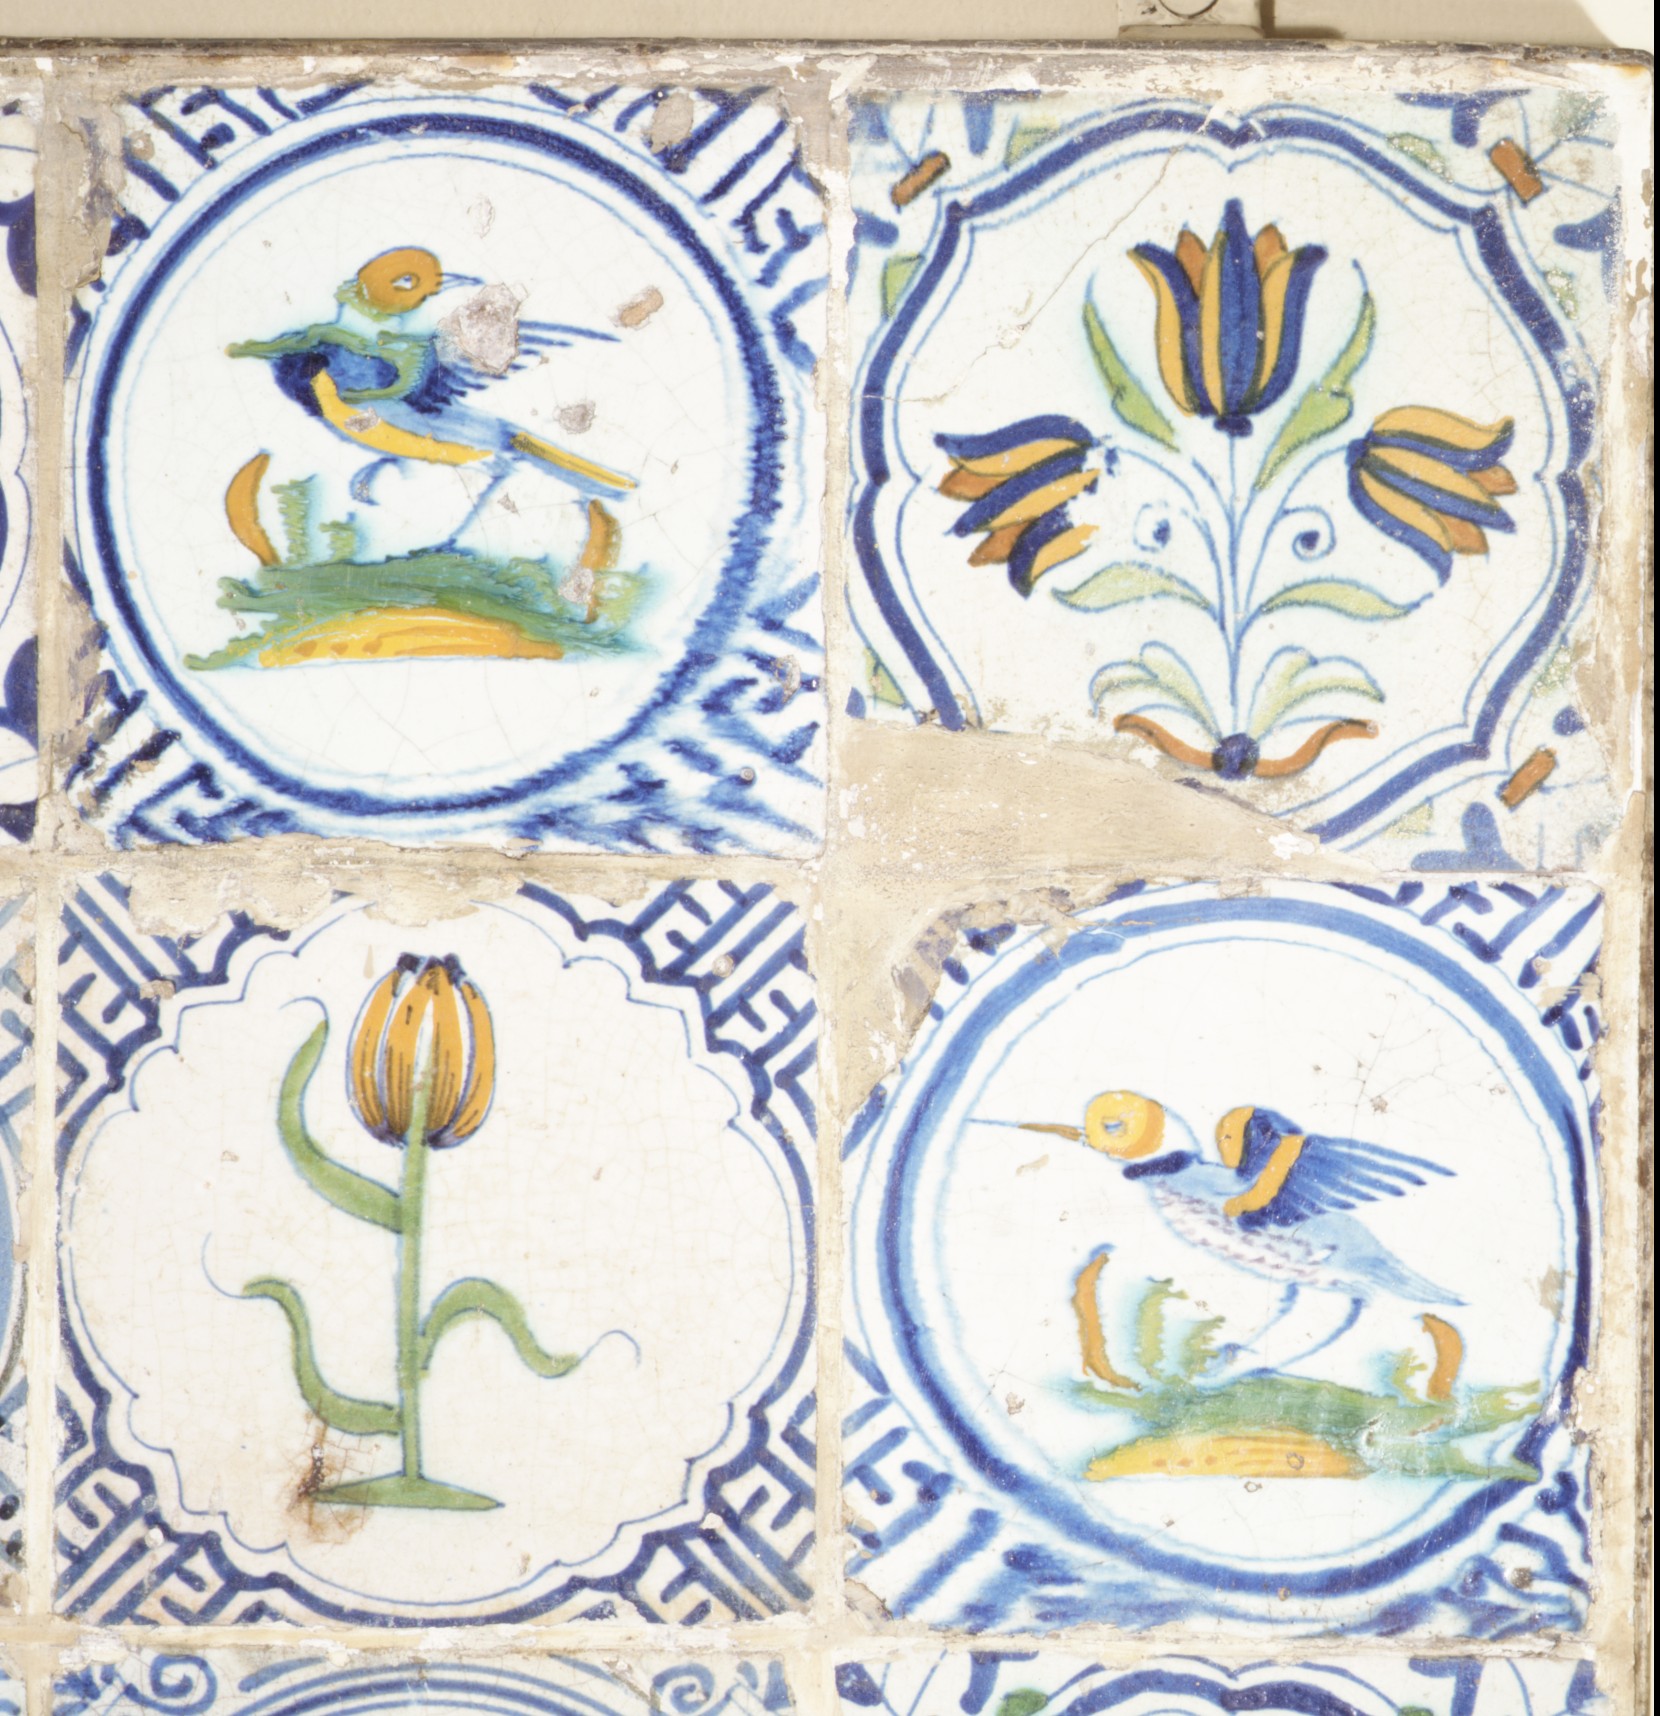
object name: tile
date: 1640-1660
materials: earthenware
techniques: glazing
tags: birds,flowers